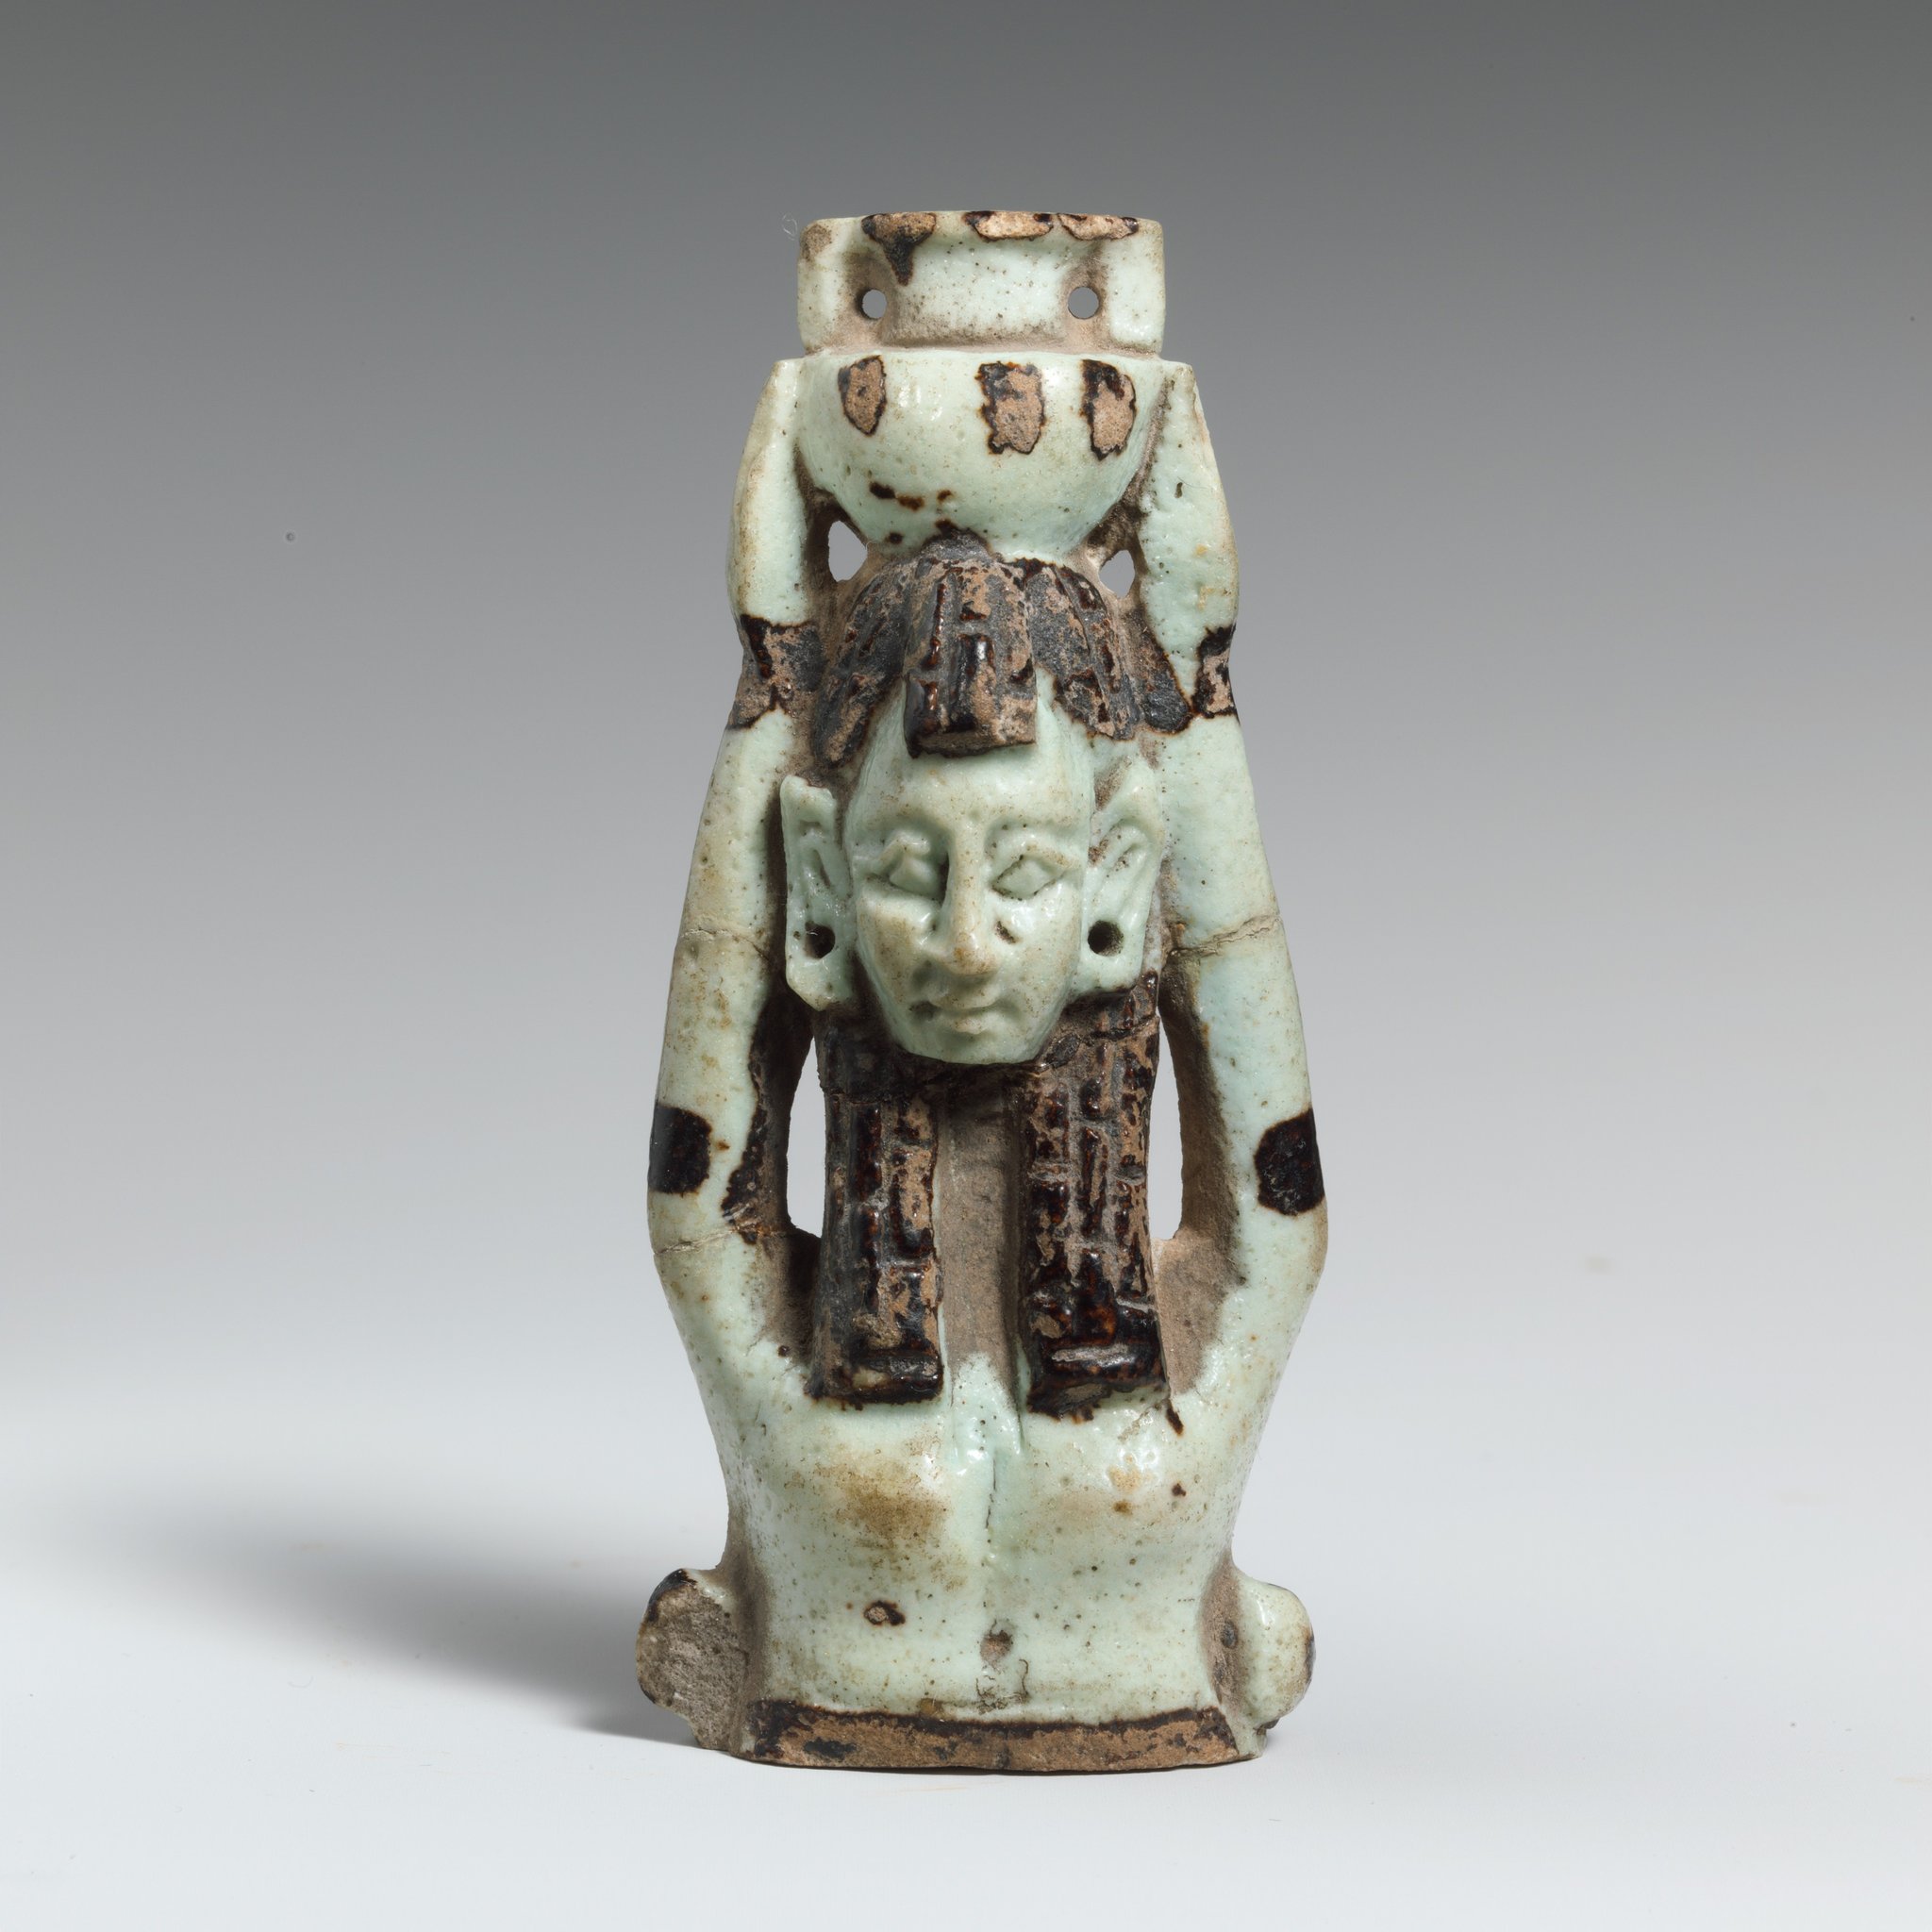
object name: statuette of a woman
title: Fragment of a faience statuette of a woman holding a vase on her head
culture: east greek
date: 634-501 BCE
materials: faience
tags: women,vases